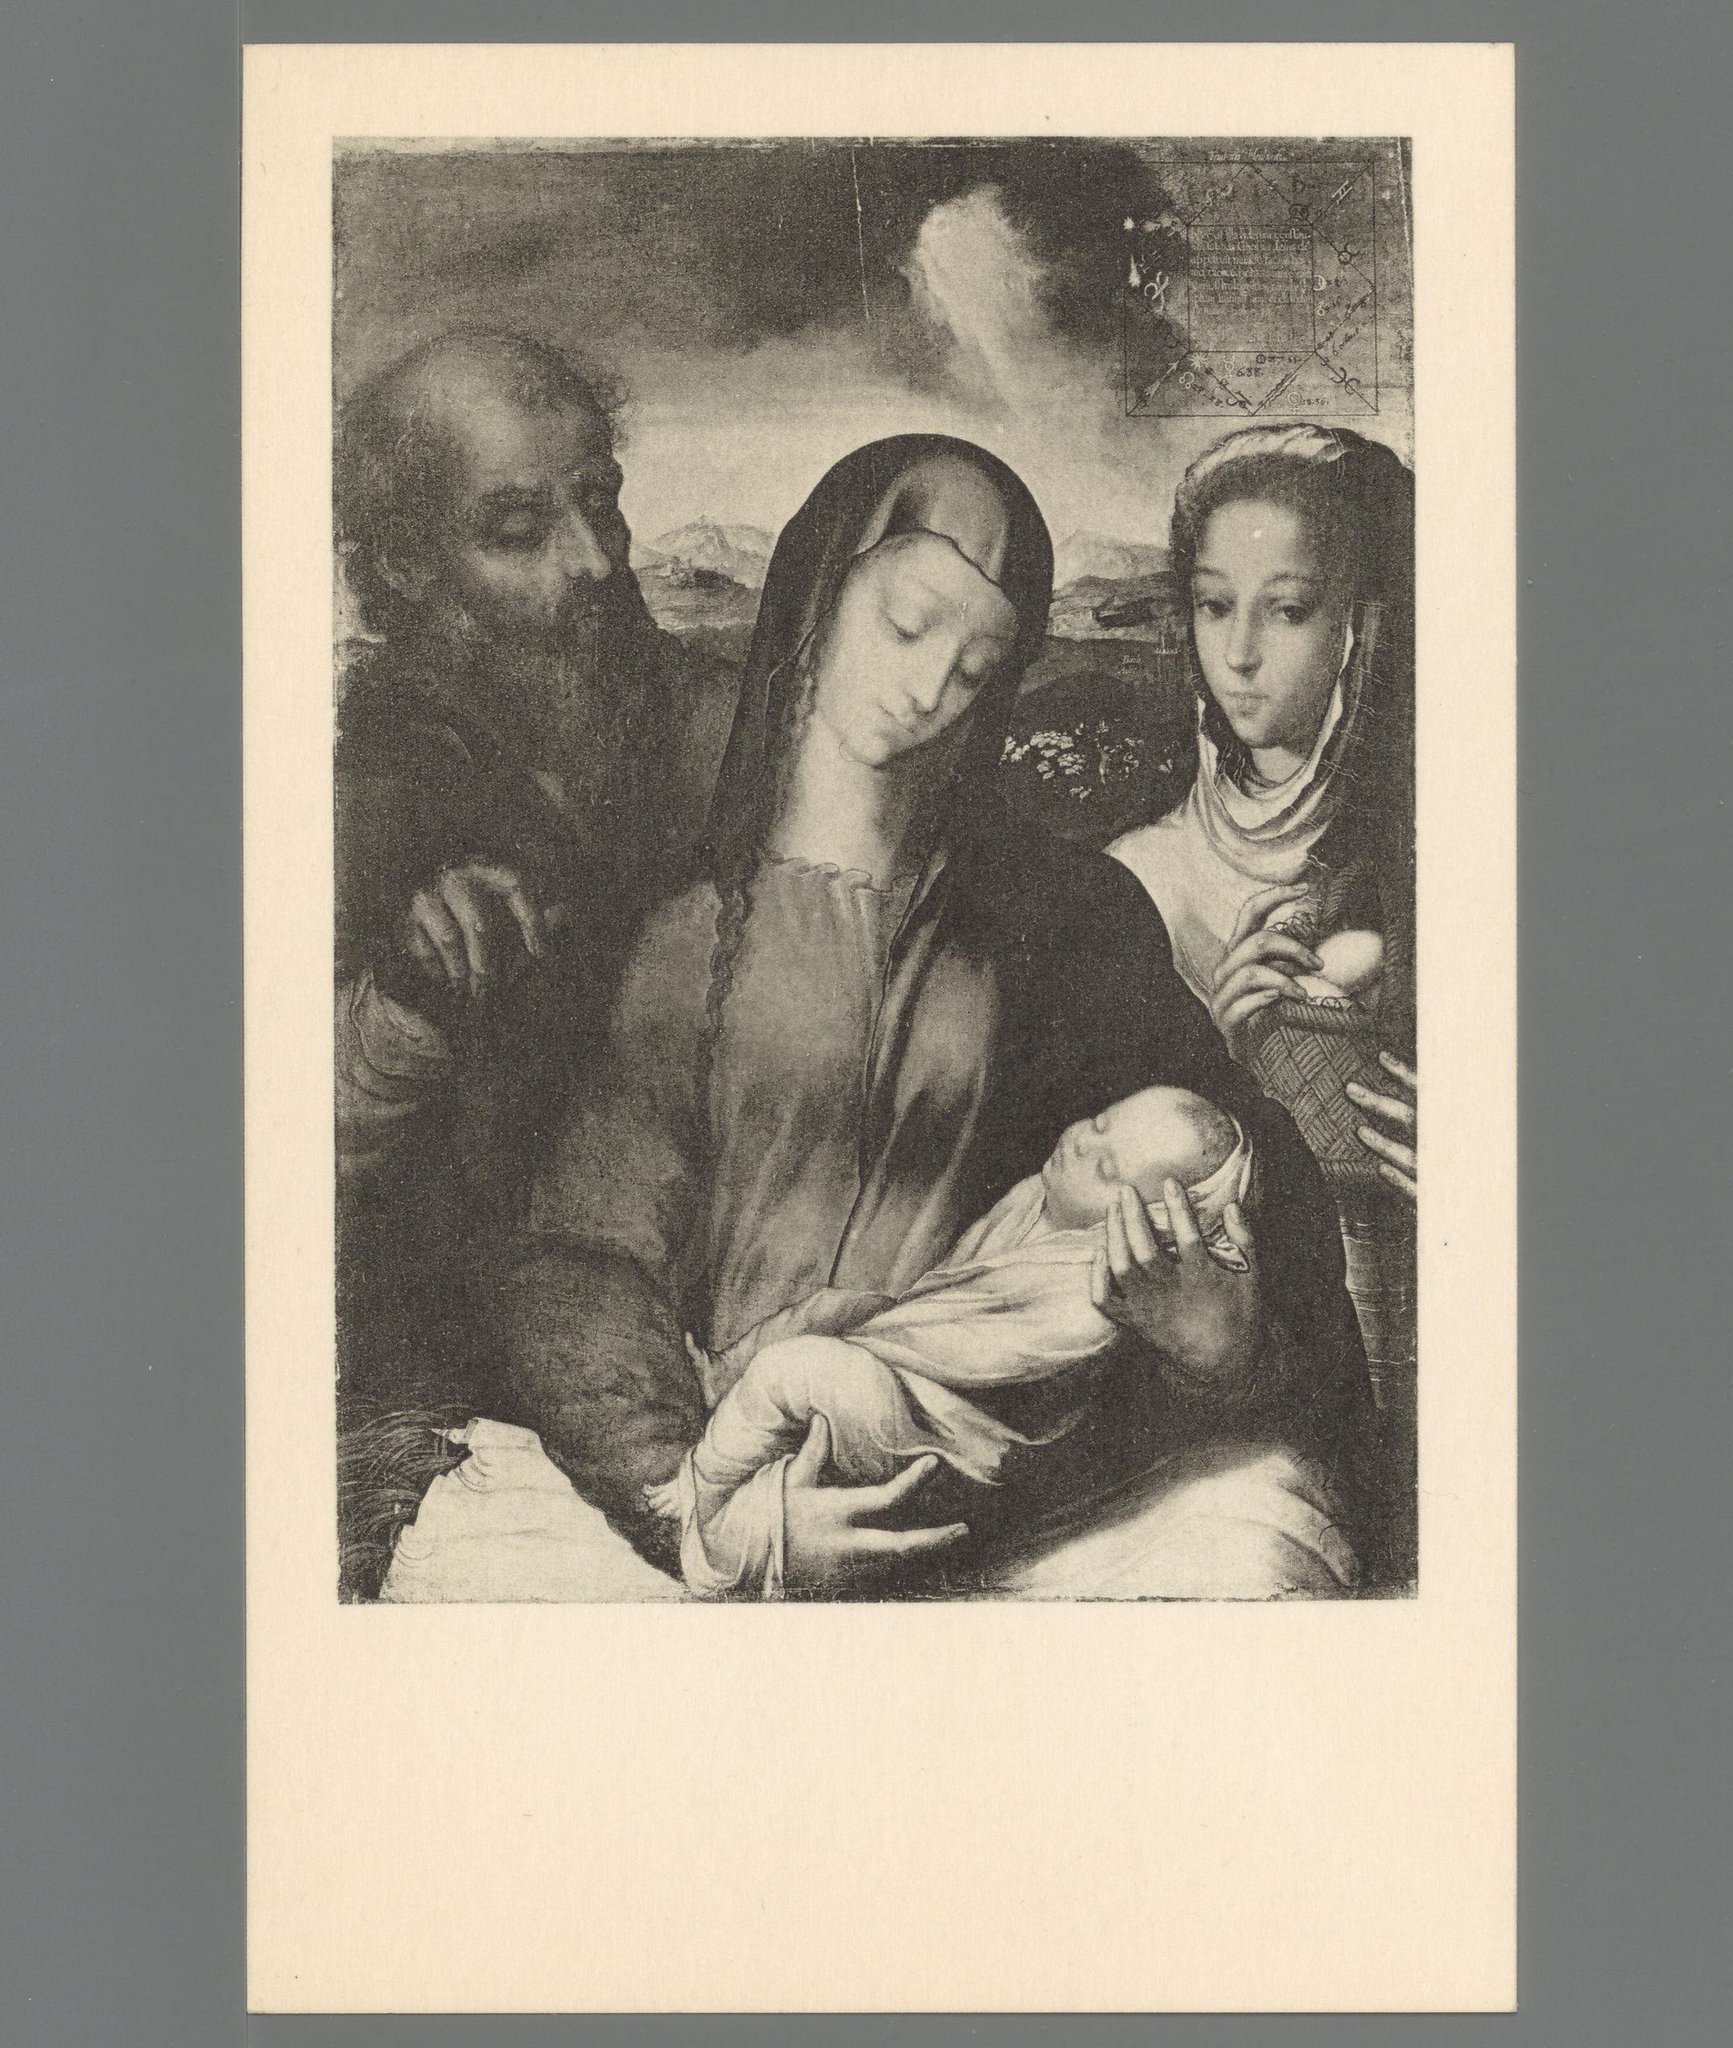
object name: photomechanical print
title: Holy Family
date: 1904-1940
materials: cardboard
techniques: photograph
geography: new york city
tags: madonna: mary sitting or enthroned, the christ-child in her lap (or in front of her bosom) (mary sometimes represented half-length), holy family, and derived representations